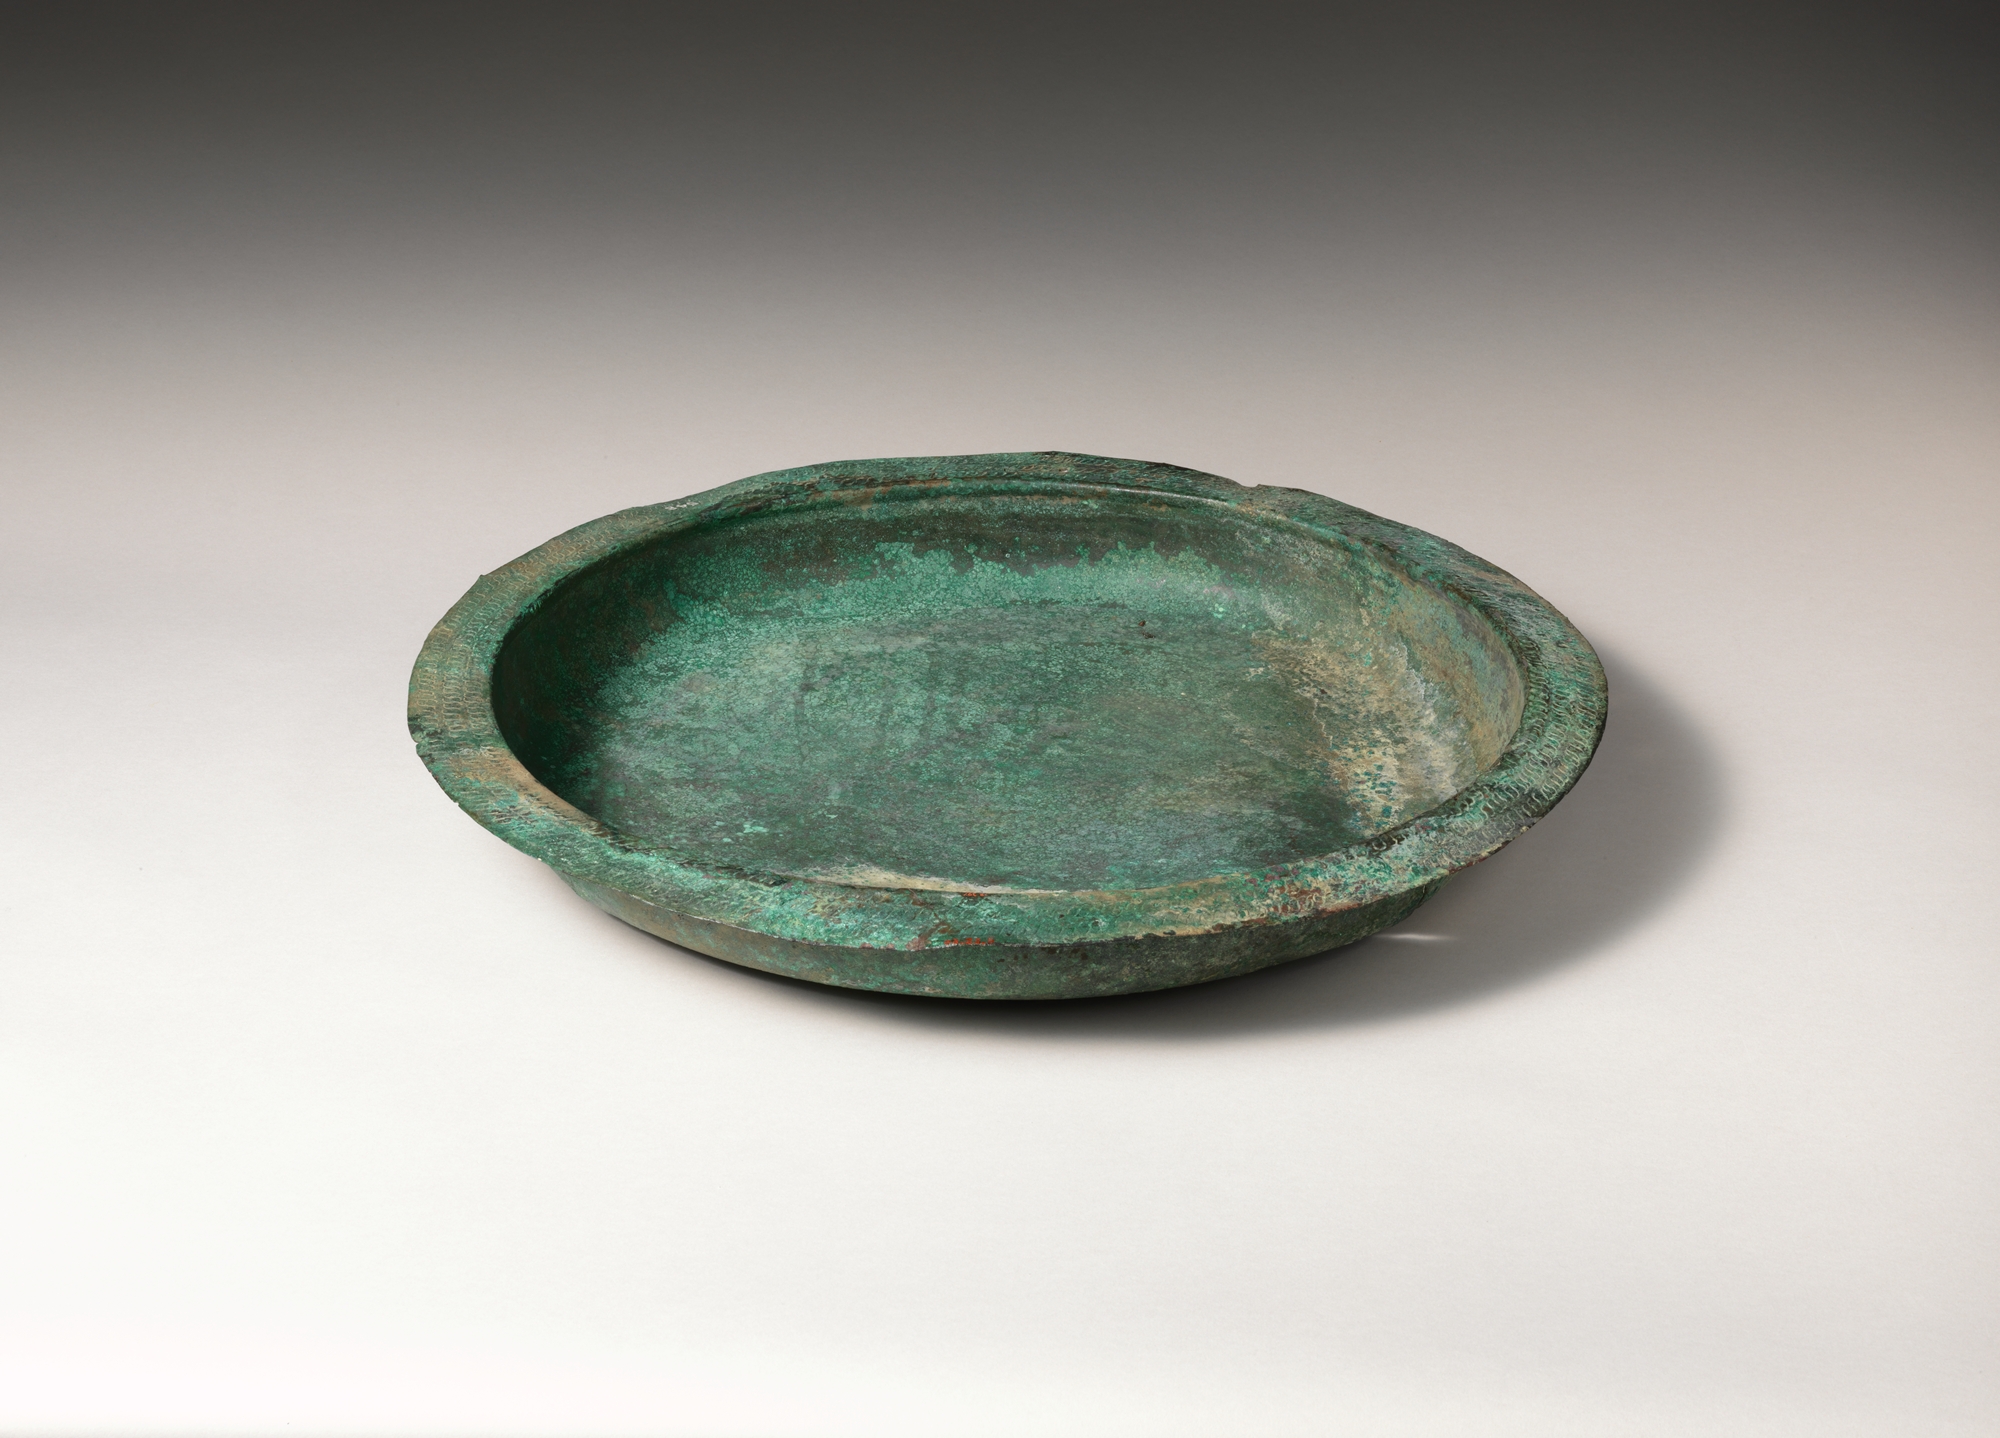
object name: patera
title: Bronze patera (salver)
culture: etruscan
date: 550 BCE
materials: bronze